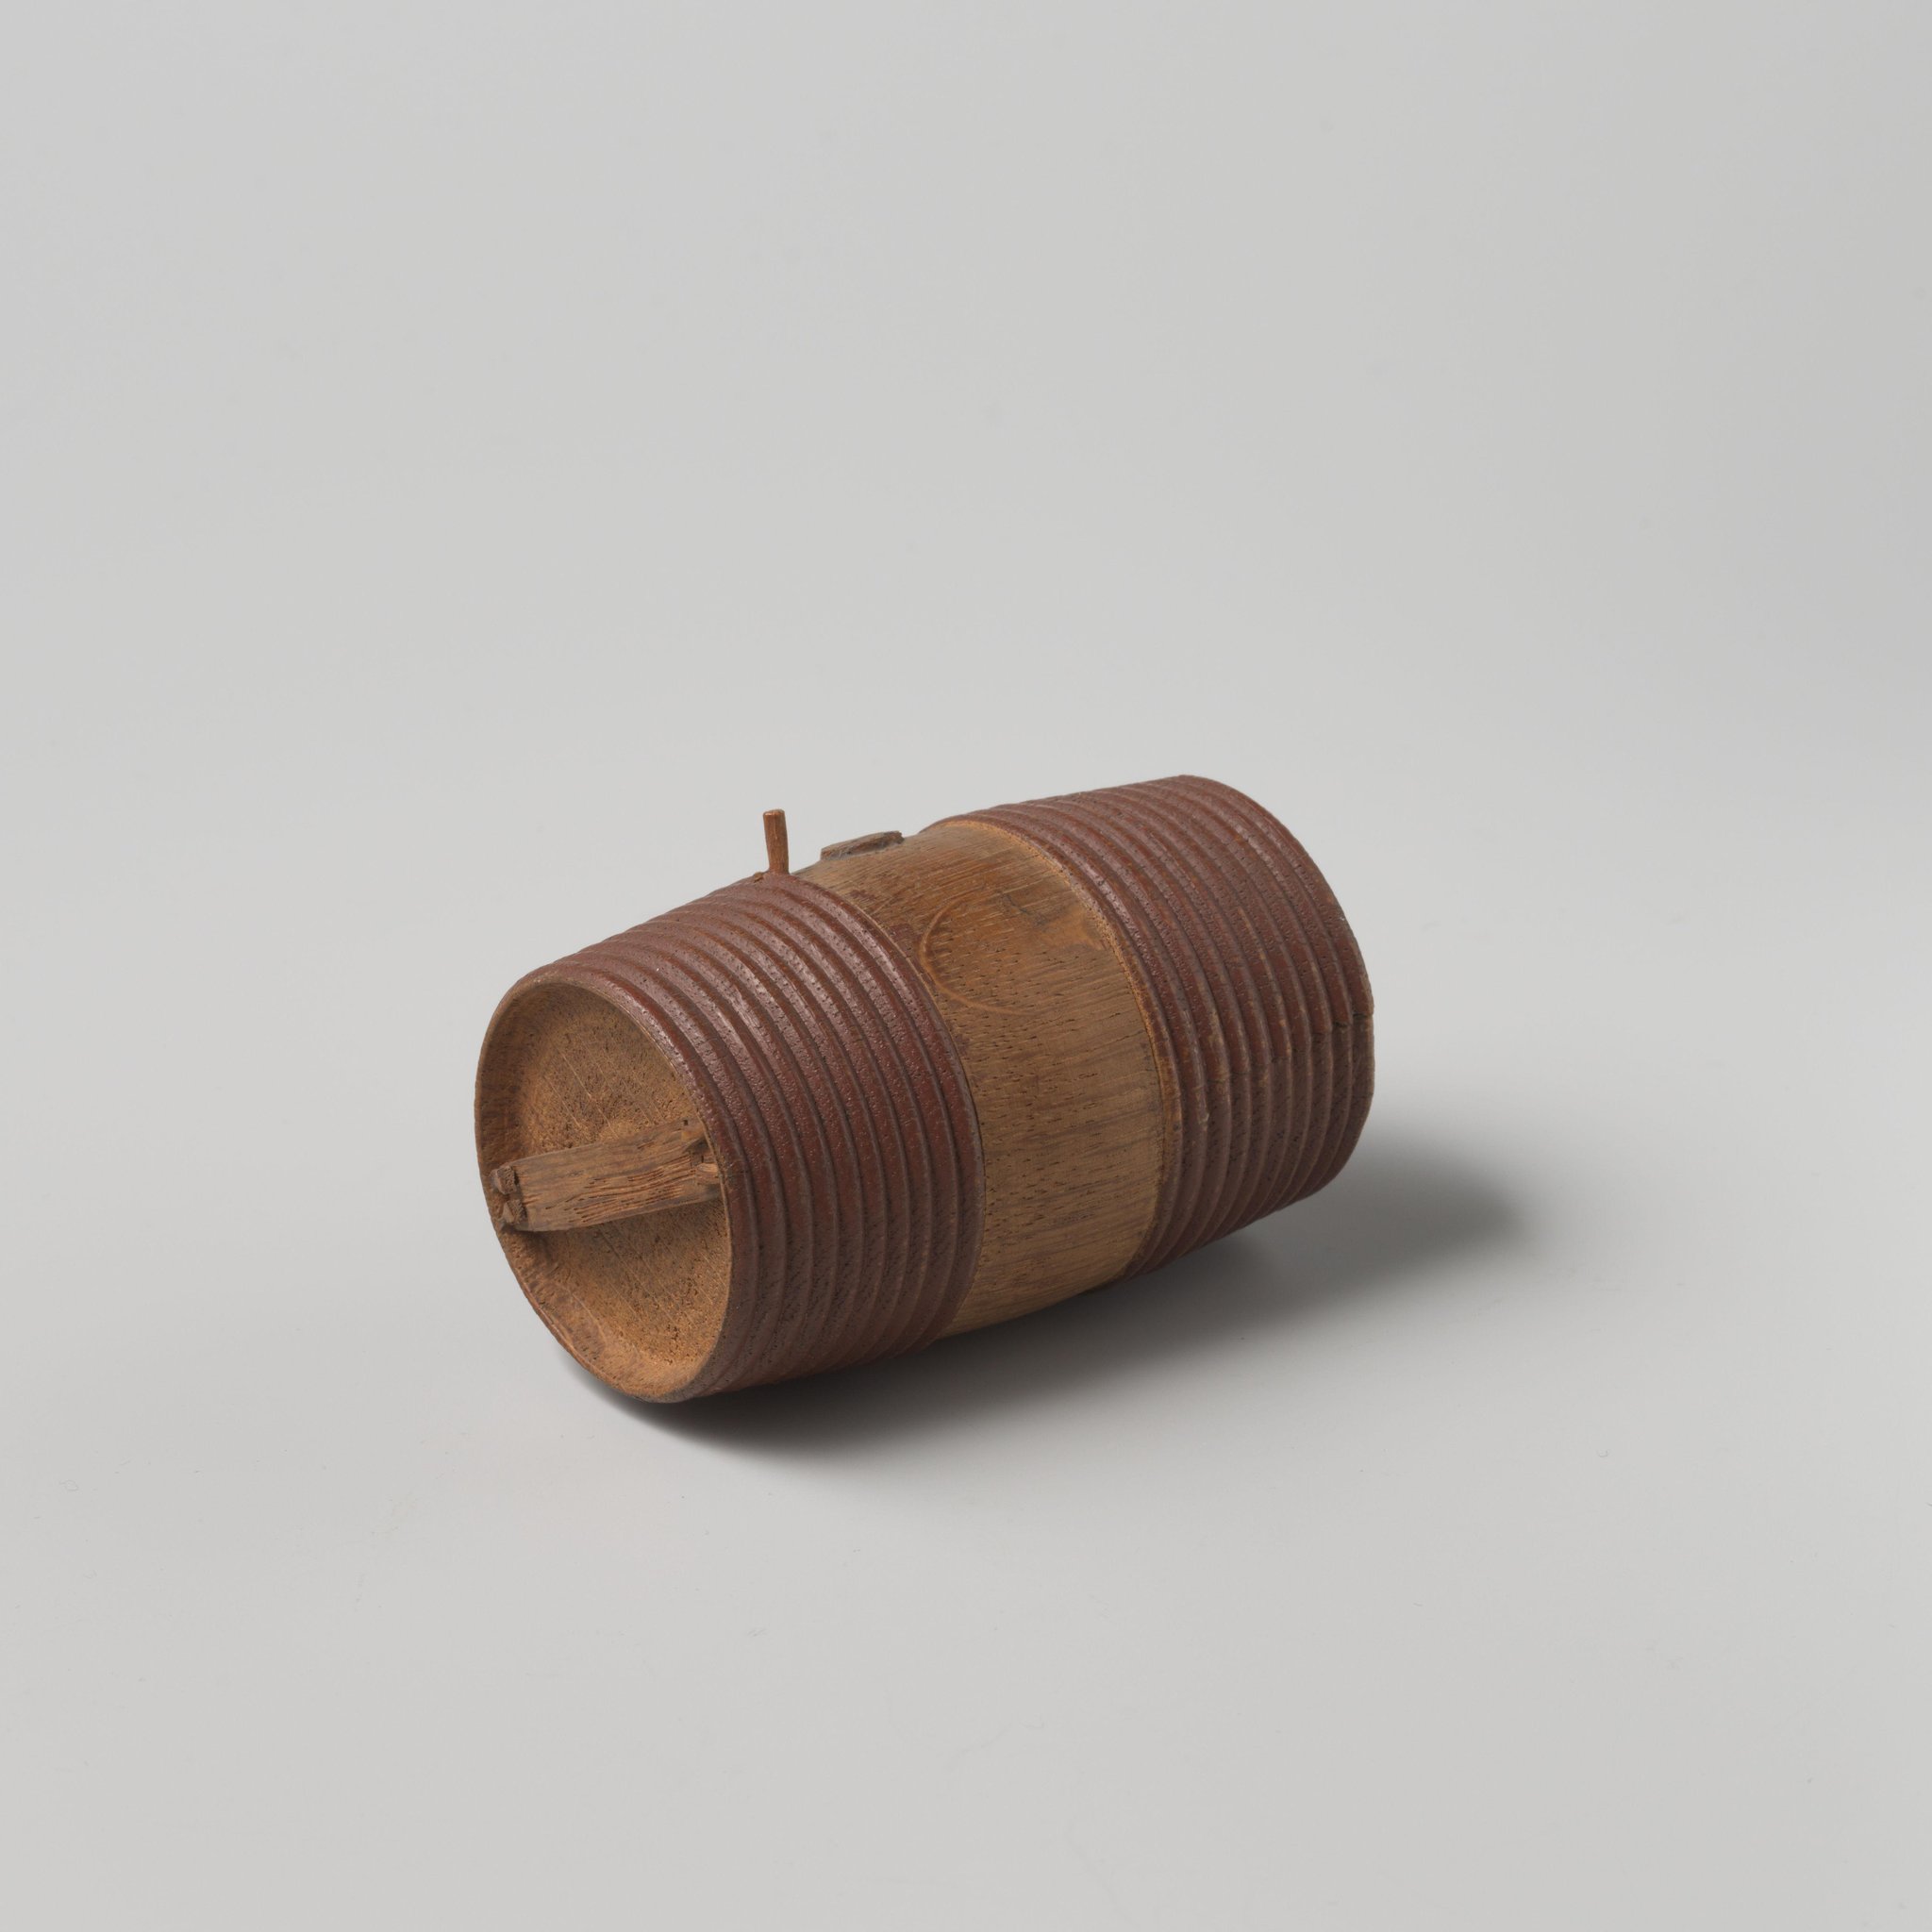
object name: wijnvat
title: Wijnvat van eikenhout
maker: Anonymous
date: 1676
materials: wood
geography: amsterdam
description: Wijnvat van eikenhout, gedraaid uit een massief blok hout, met ringen (hoepels voorstellende), een spongat met stop bovenop, en een gat voor een tapkraan in de voorzijde. De ronde voor en achterplaat van de vaten worden extra vastgeklemd door een latje dat door twee maal twee wiggen wordt vastgezet.